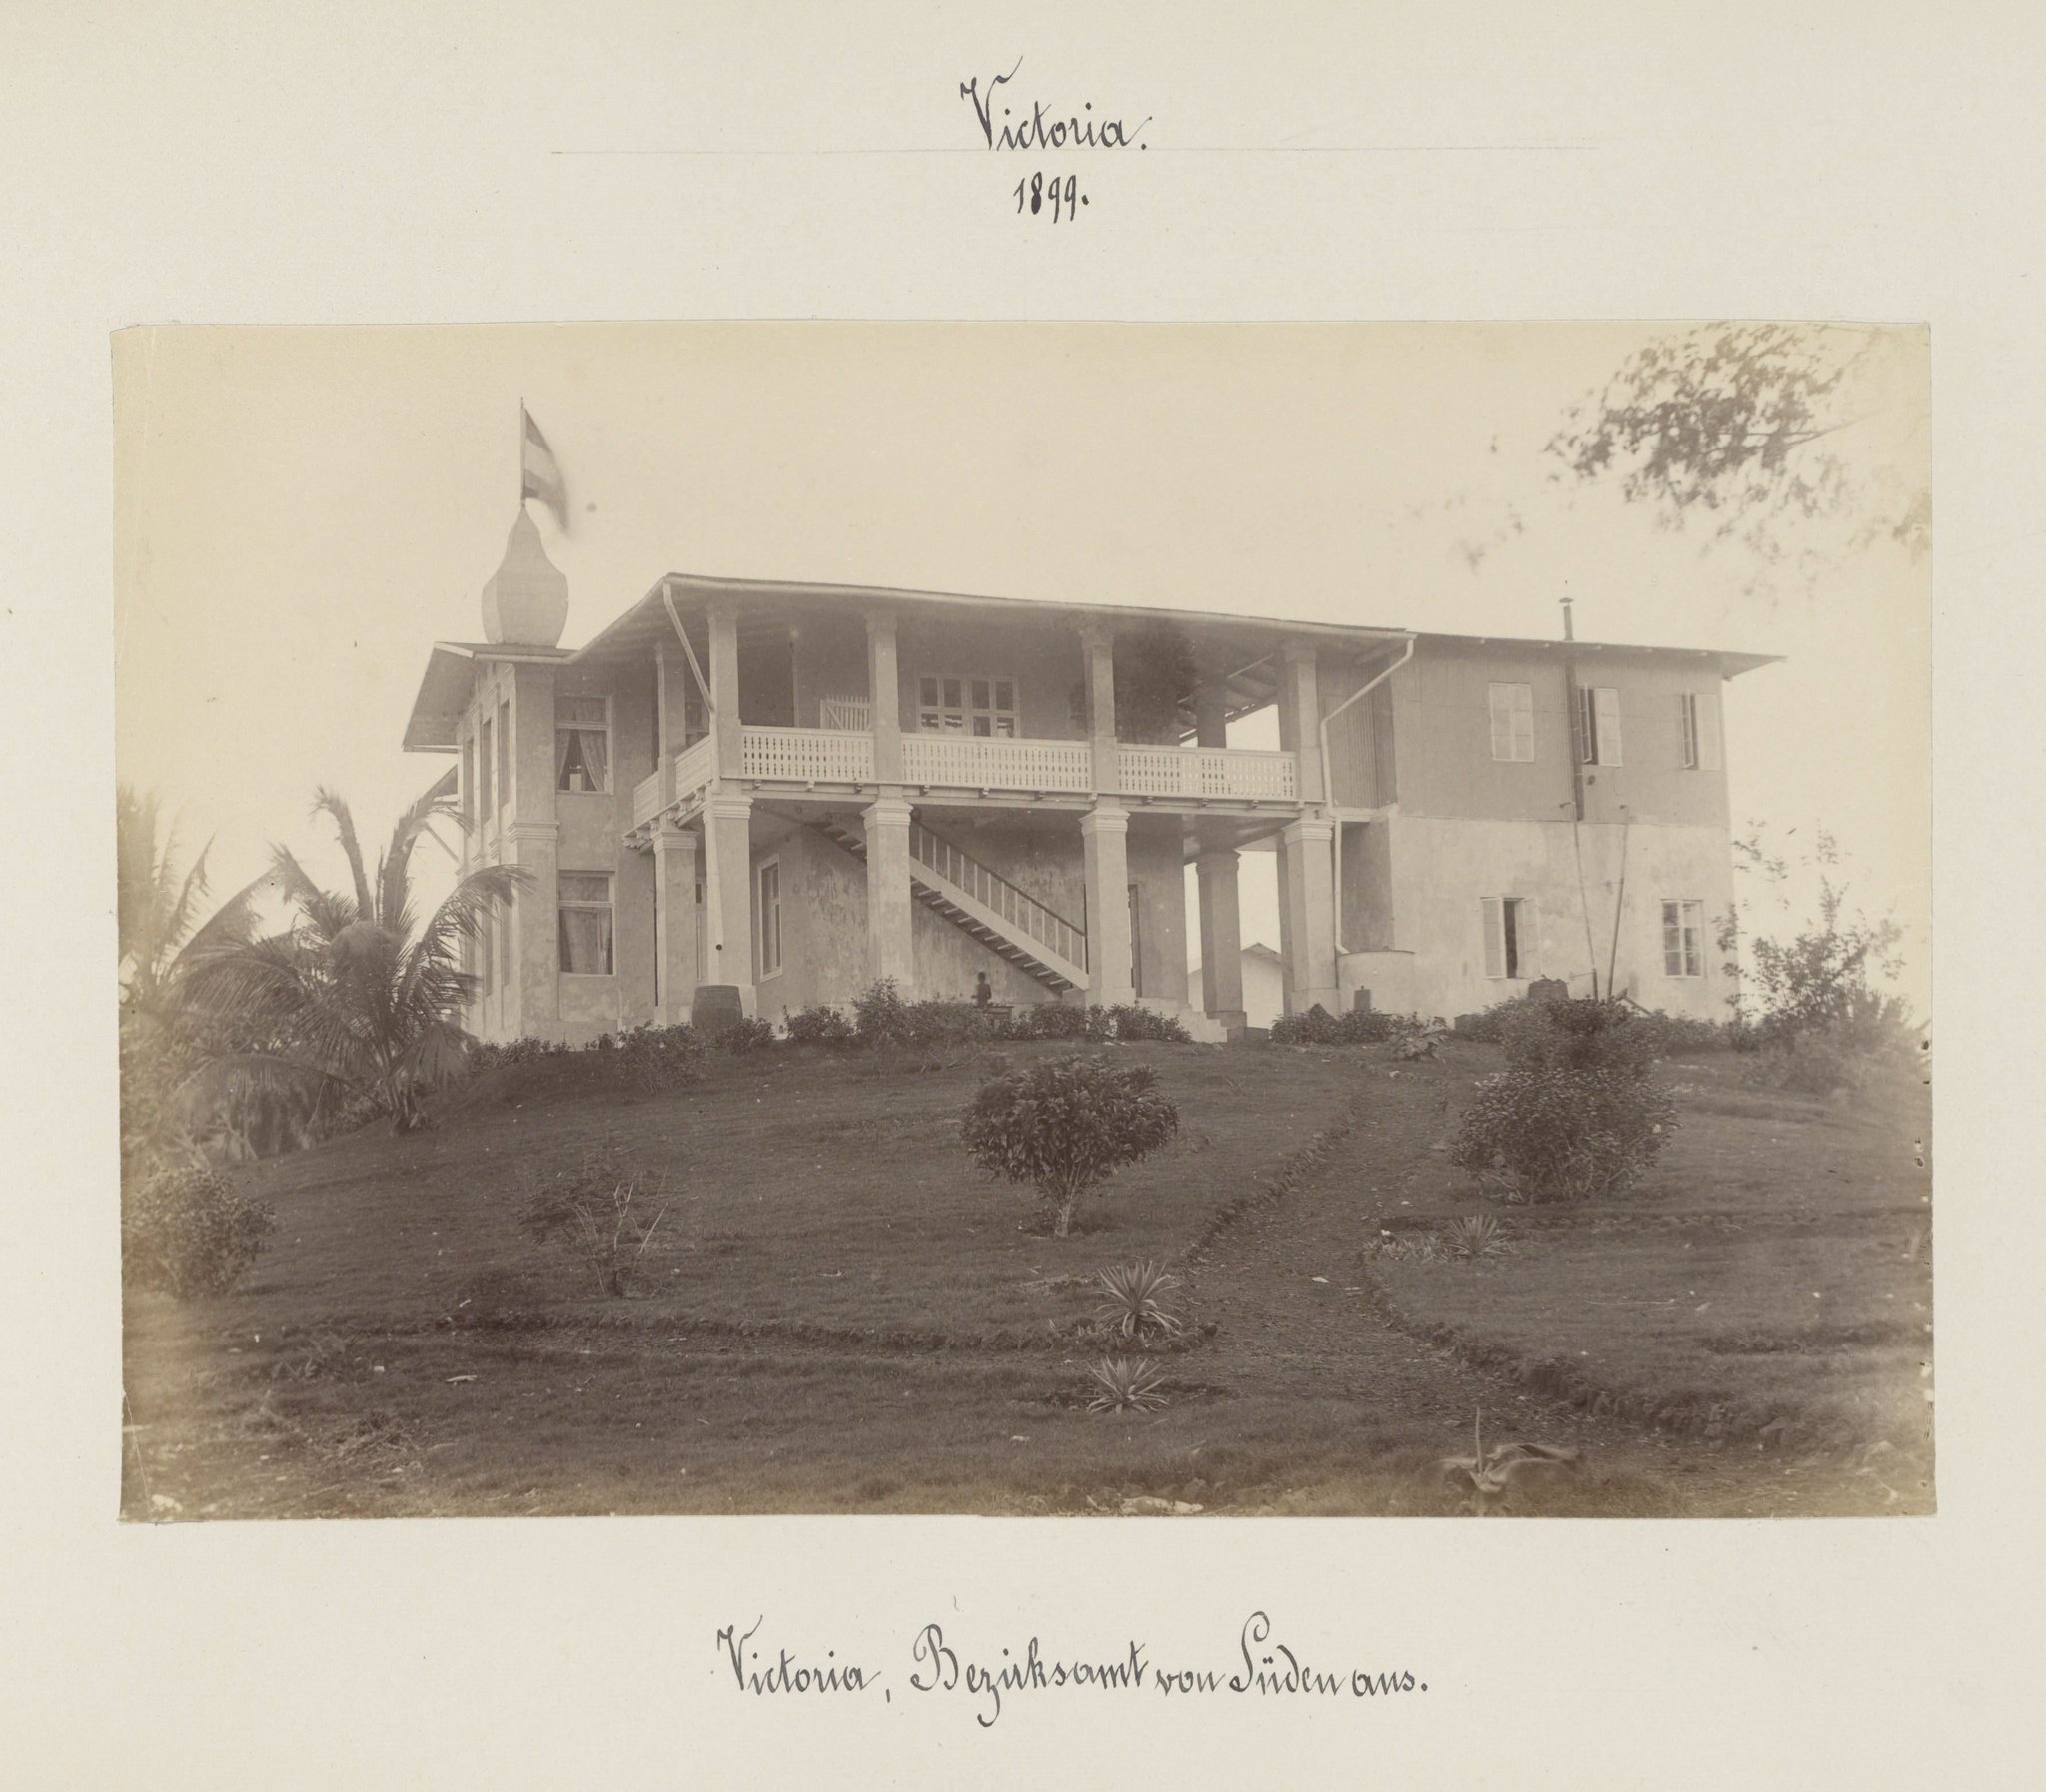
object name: photograph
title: Exterieur van een districtsgebouw in Victoria (Kameroen)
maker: Anonymous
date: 1899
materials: photographic support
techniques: albumen print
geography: victoria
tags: trade-company, colonial government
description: Onderdeel van Fotoalbum met opnames van Kameroen rond 1899.